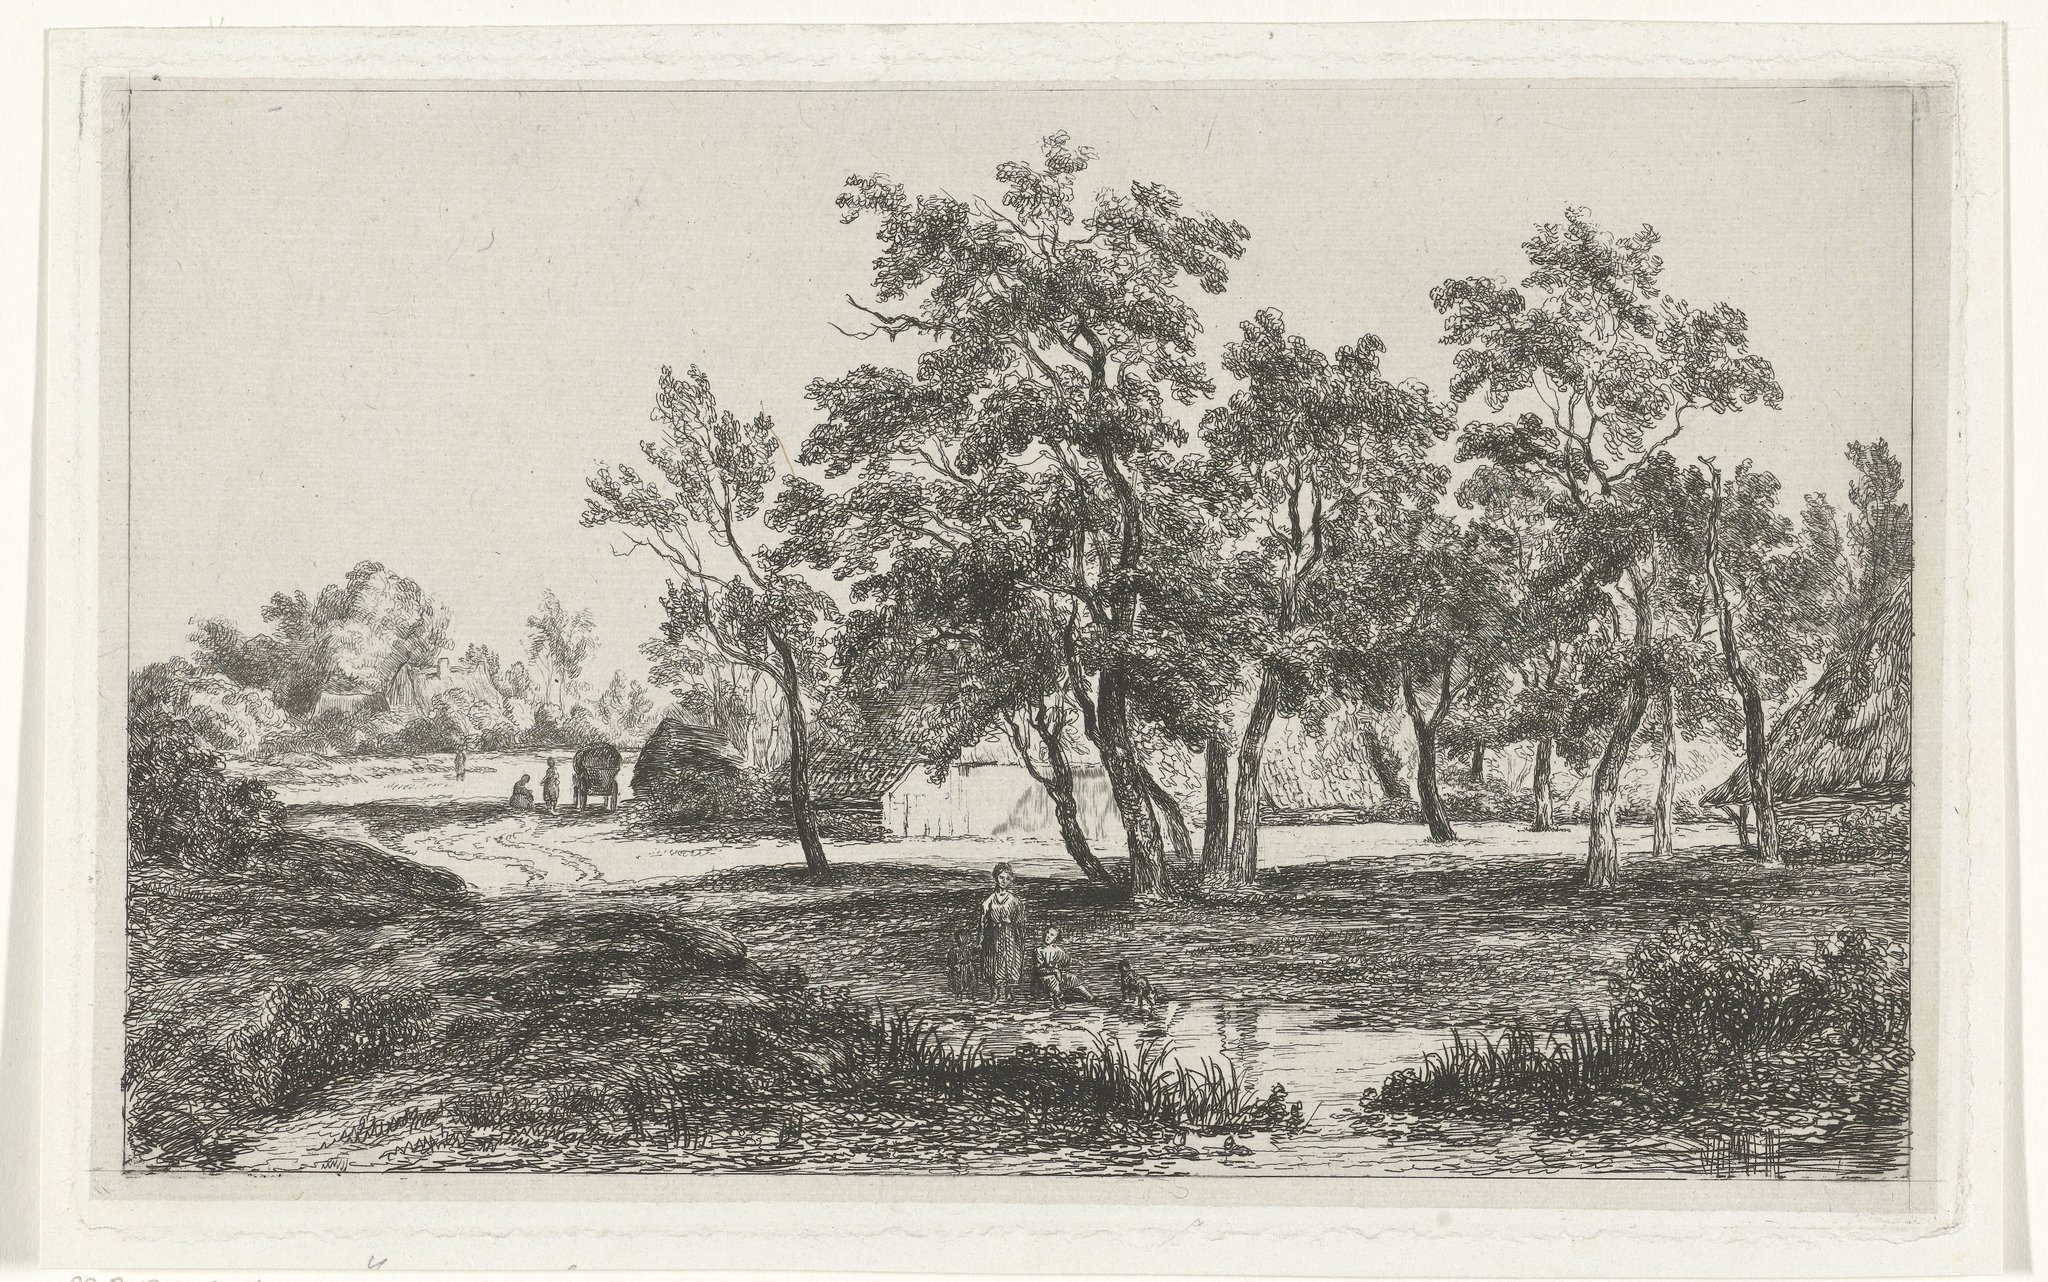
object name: print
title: Landschap met boerderij tussen de bomen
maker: christiaan immerzeel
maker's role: print maker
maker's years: 1808-1886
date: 1818-1886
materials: paper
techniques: etching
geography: netherlands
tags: landscapes (+ landscape with figures, staffage), farm or solitary house in landscape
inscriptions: collector's mark: Lugt 2228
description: Landschap met drie figuren en een hond bij een waterplas. Daarachter ligt een boerderij tussen de bomen. Links een weg met figuren en een kar.